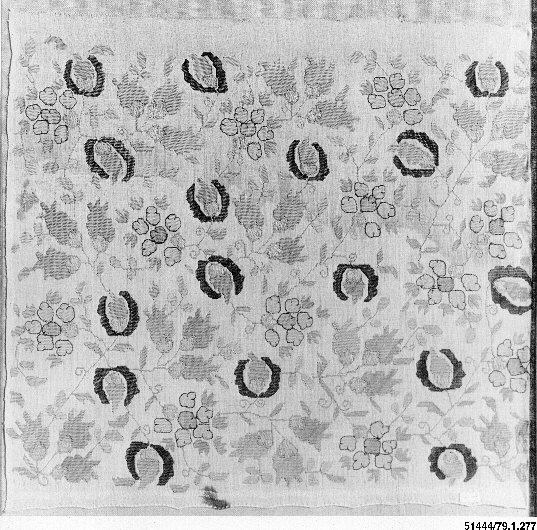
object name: textile fragment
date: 1801-1833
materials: linen, metal thread, silk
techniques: embroidery, weave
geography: turkey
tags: leaves